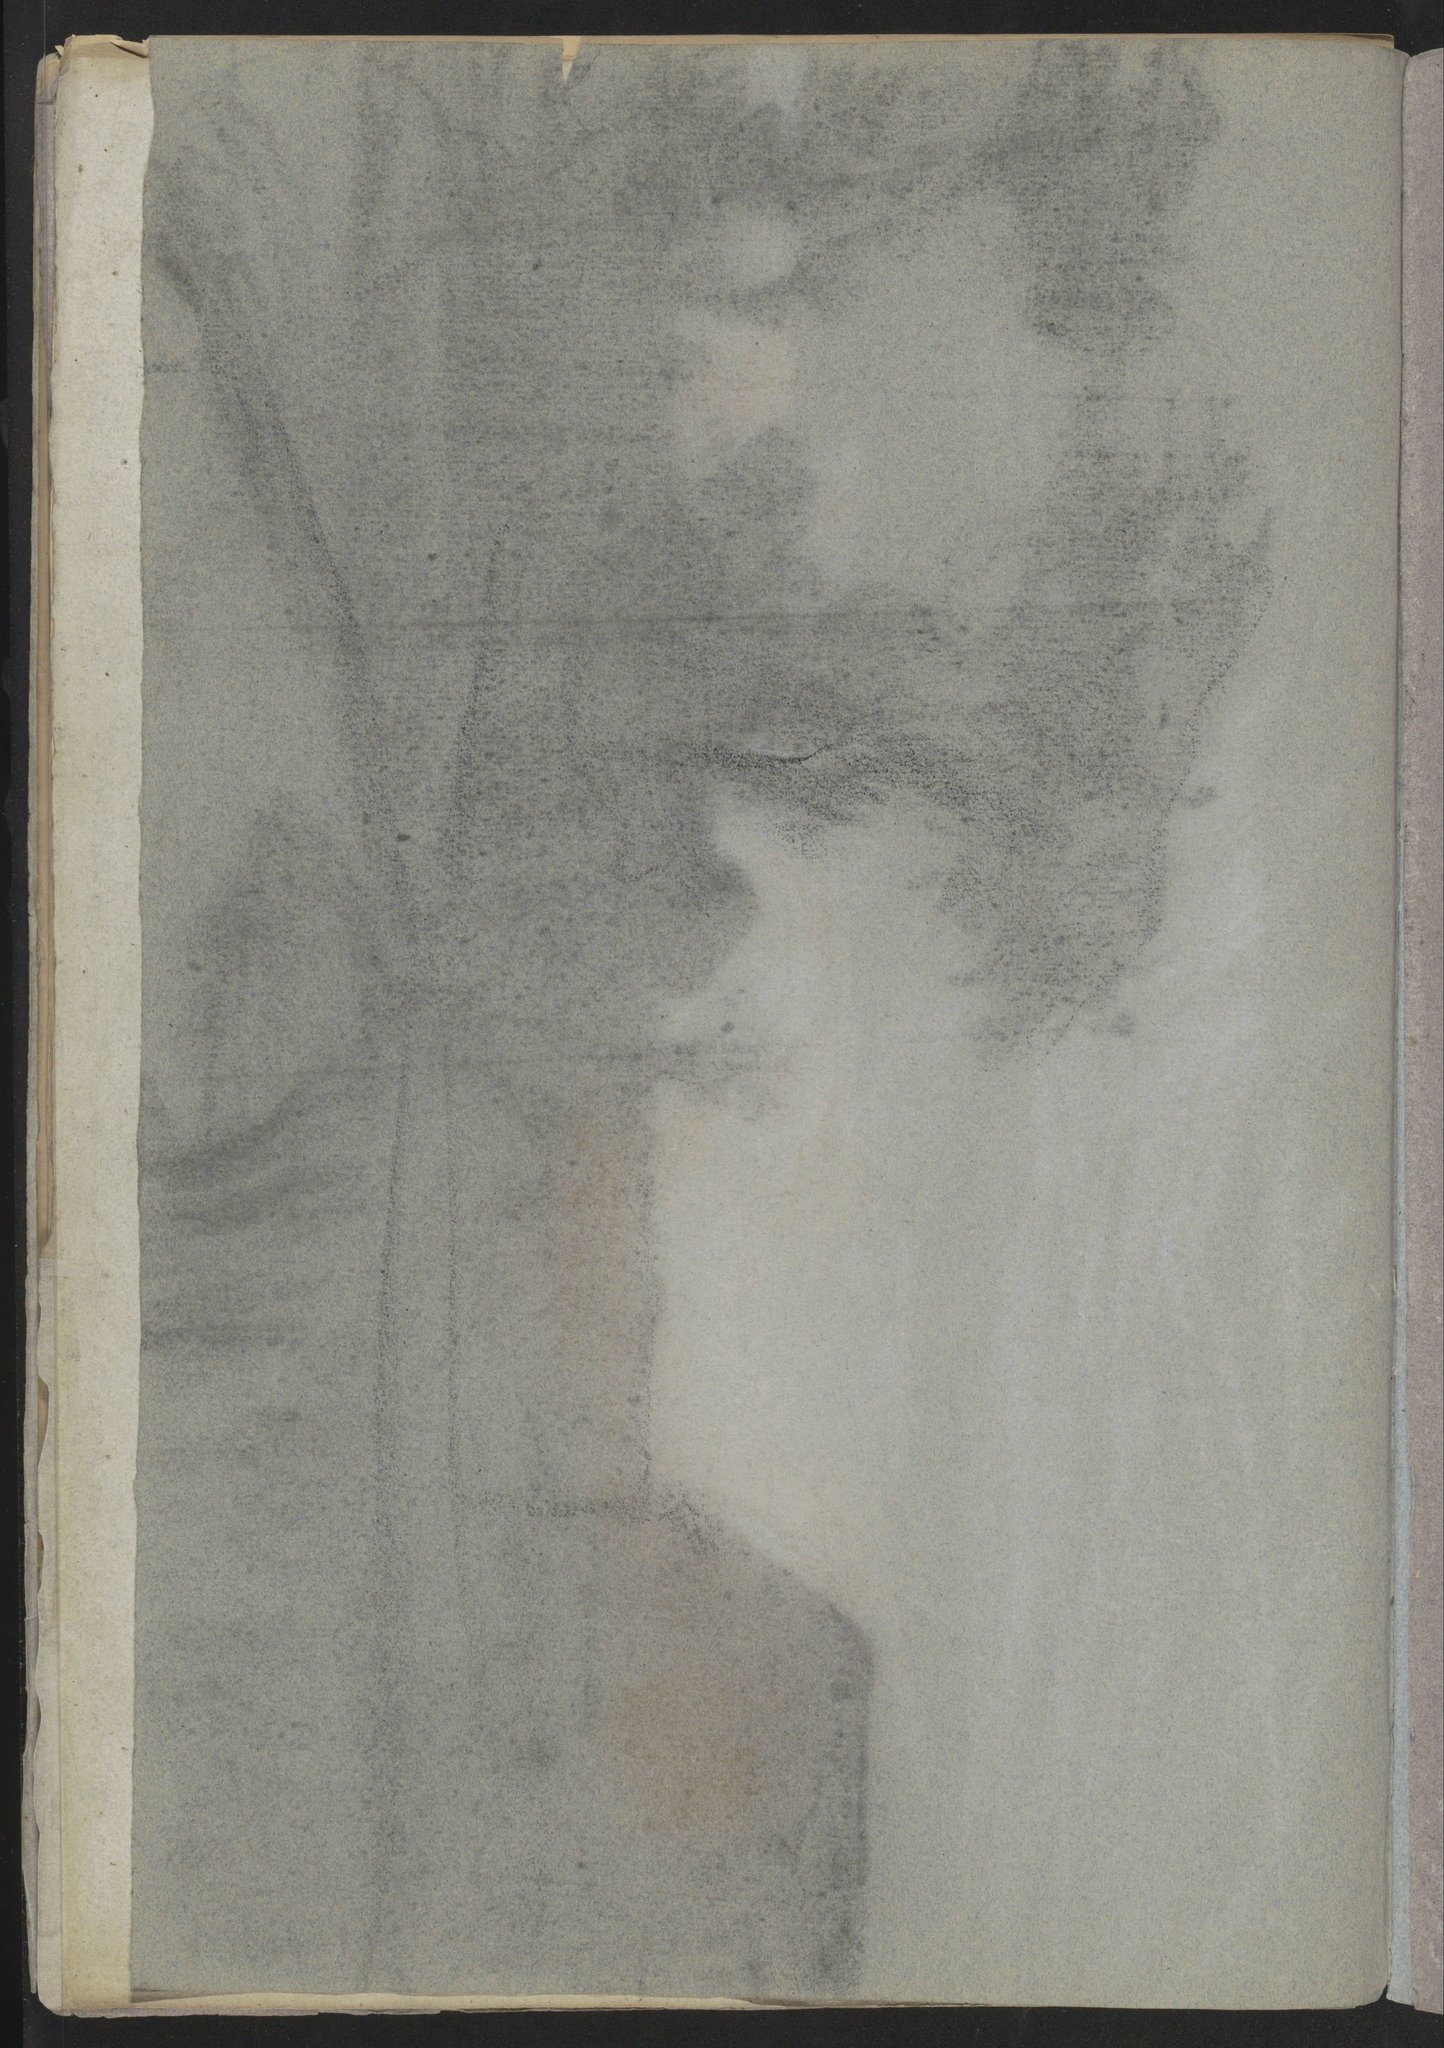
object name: sketchbook leaf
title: Abklatsch van de krijttekening op pagina 16 recto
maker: jan veth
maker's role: designer, draughtsman, painter, print maker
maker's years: 1864-1925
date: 1874-1925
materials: paper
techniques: printmaking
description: Blad 15 verso uit een schetsboek met 42 bladen.